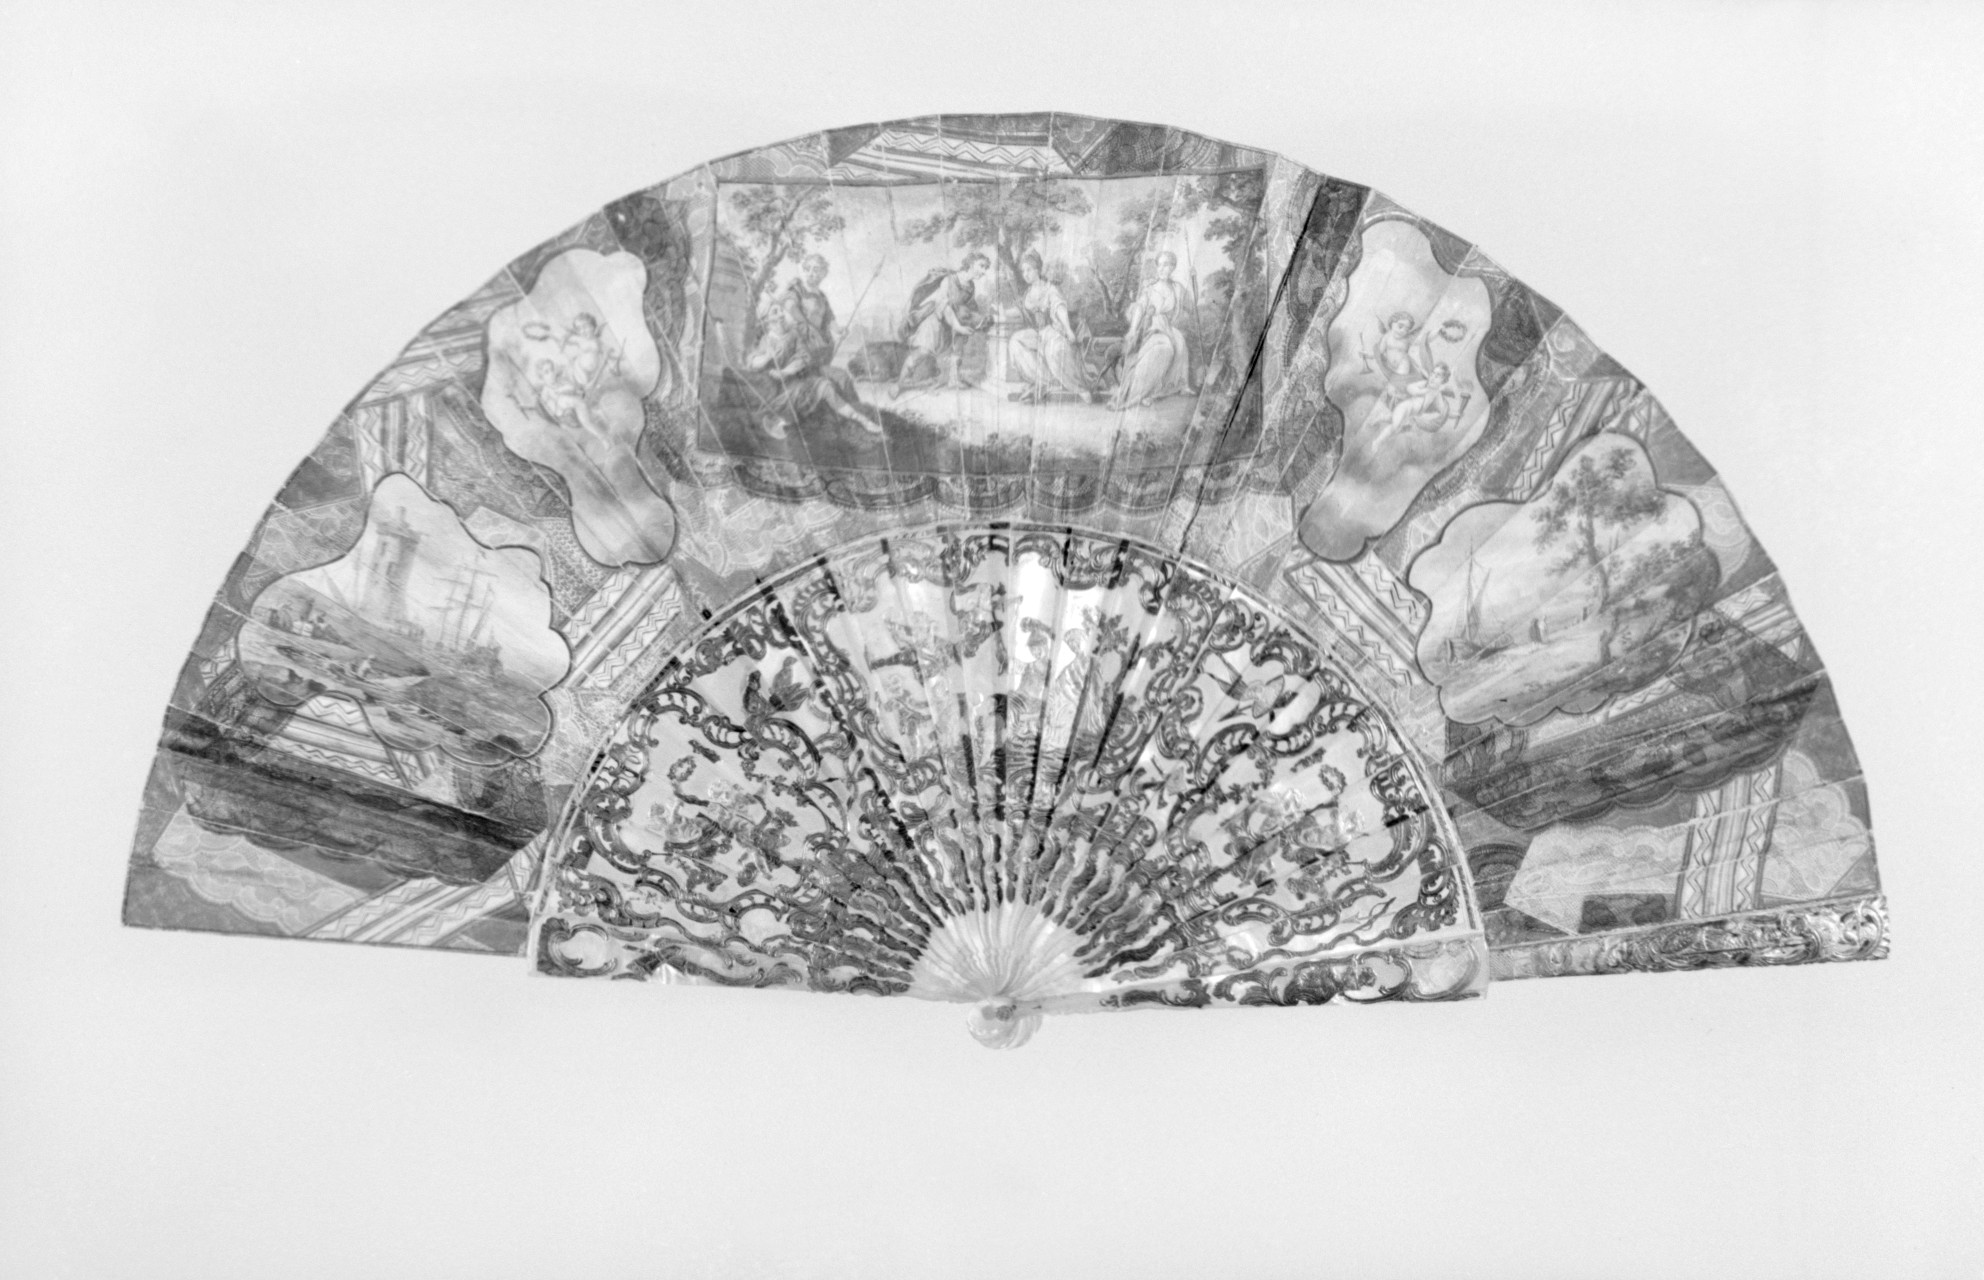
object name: fan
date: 1701-1800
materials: mother of pearl, paper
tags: men,women